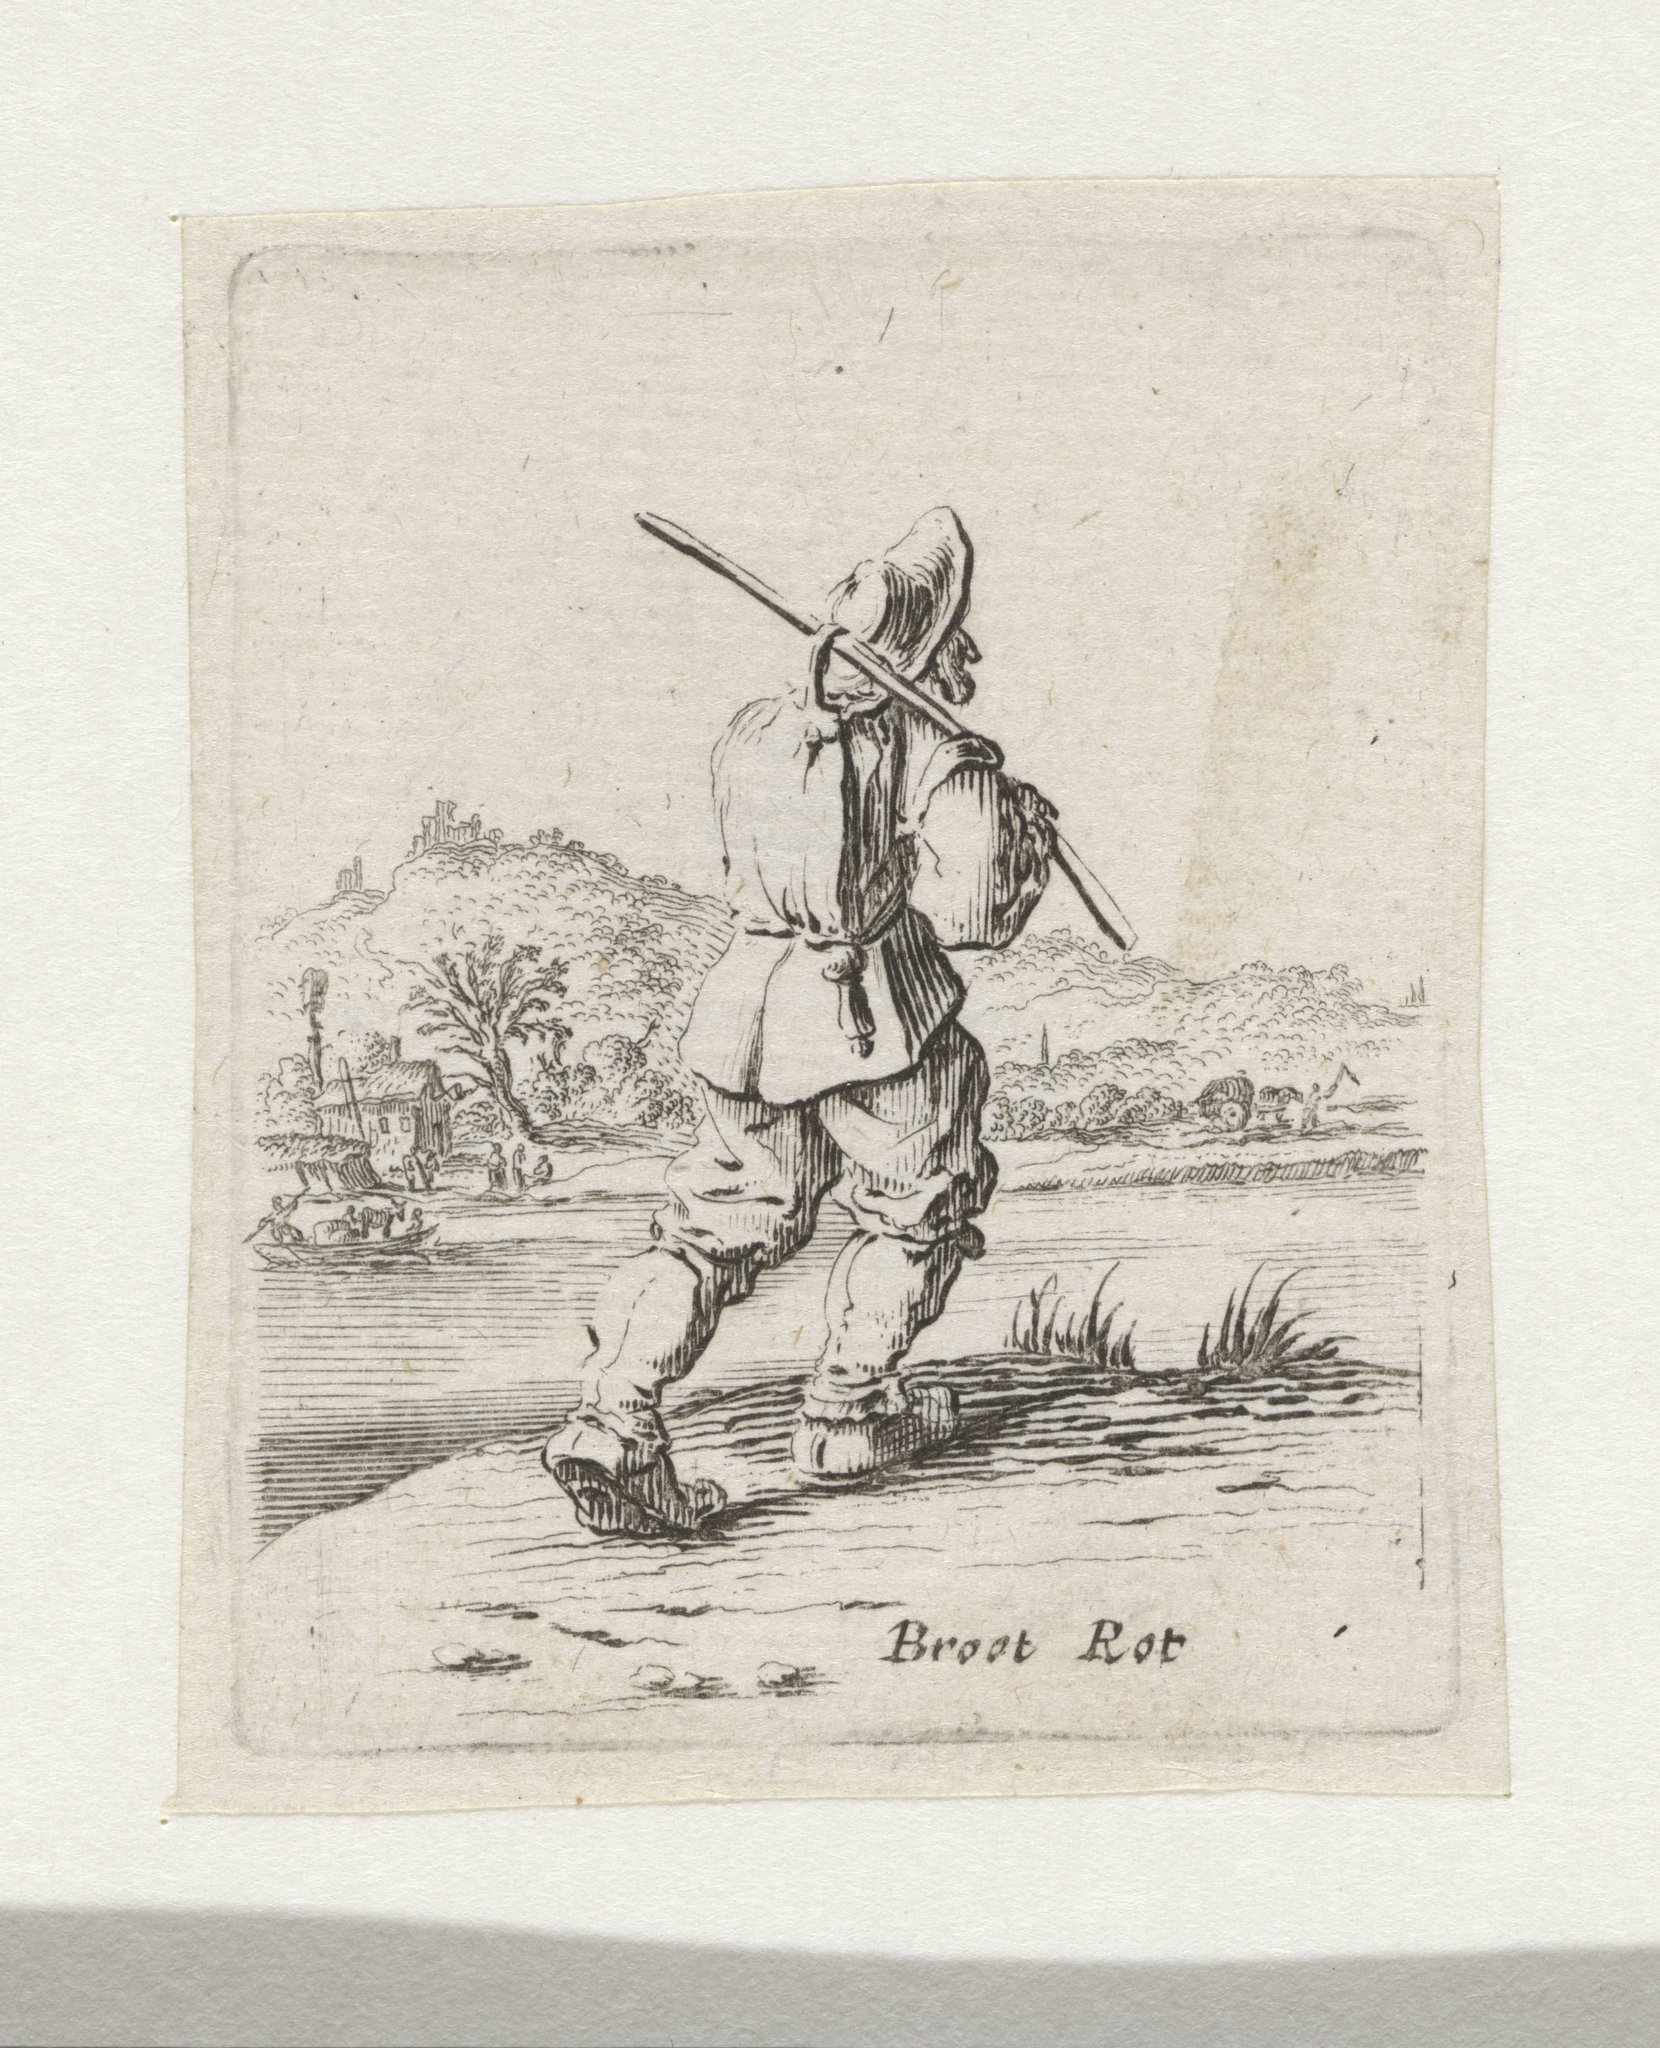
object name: print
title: Broot Rot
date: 1638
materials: paper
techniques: engraving, etching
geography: netherlands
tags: river, carrying something in basket, bag, rucksack, etc.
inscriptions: collector's mark: Lugt 2760, collector's mark: Lugt 2228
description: Een man met een knapzak loopt langs de waterkant. Op de rivier een boot en aan de overkant een heuvellandschap met huizen. De prent maakt deel uit van een serie van 32 prenten met genretaferelen.